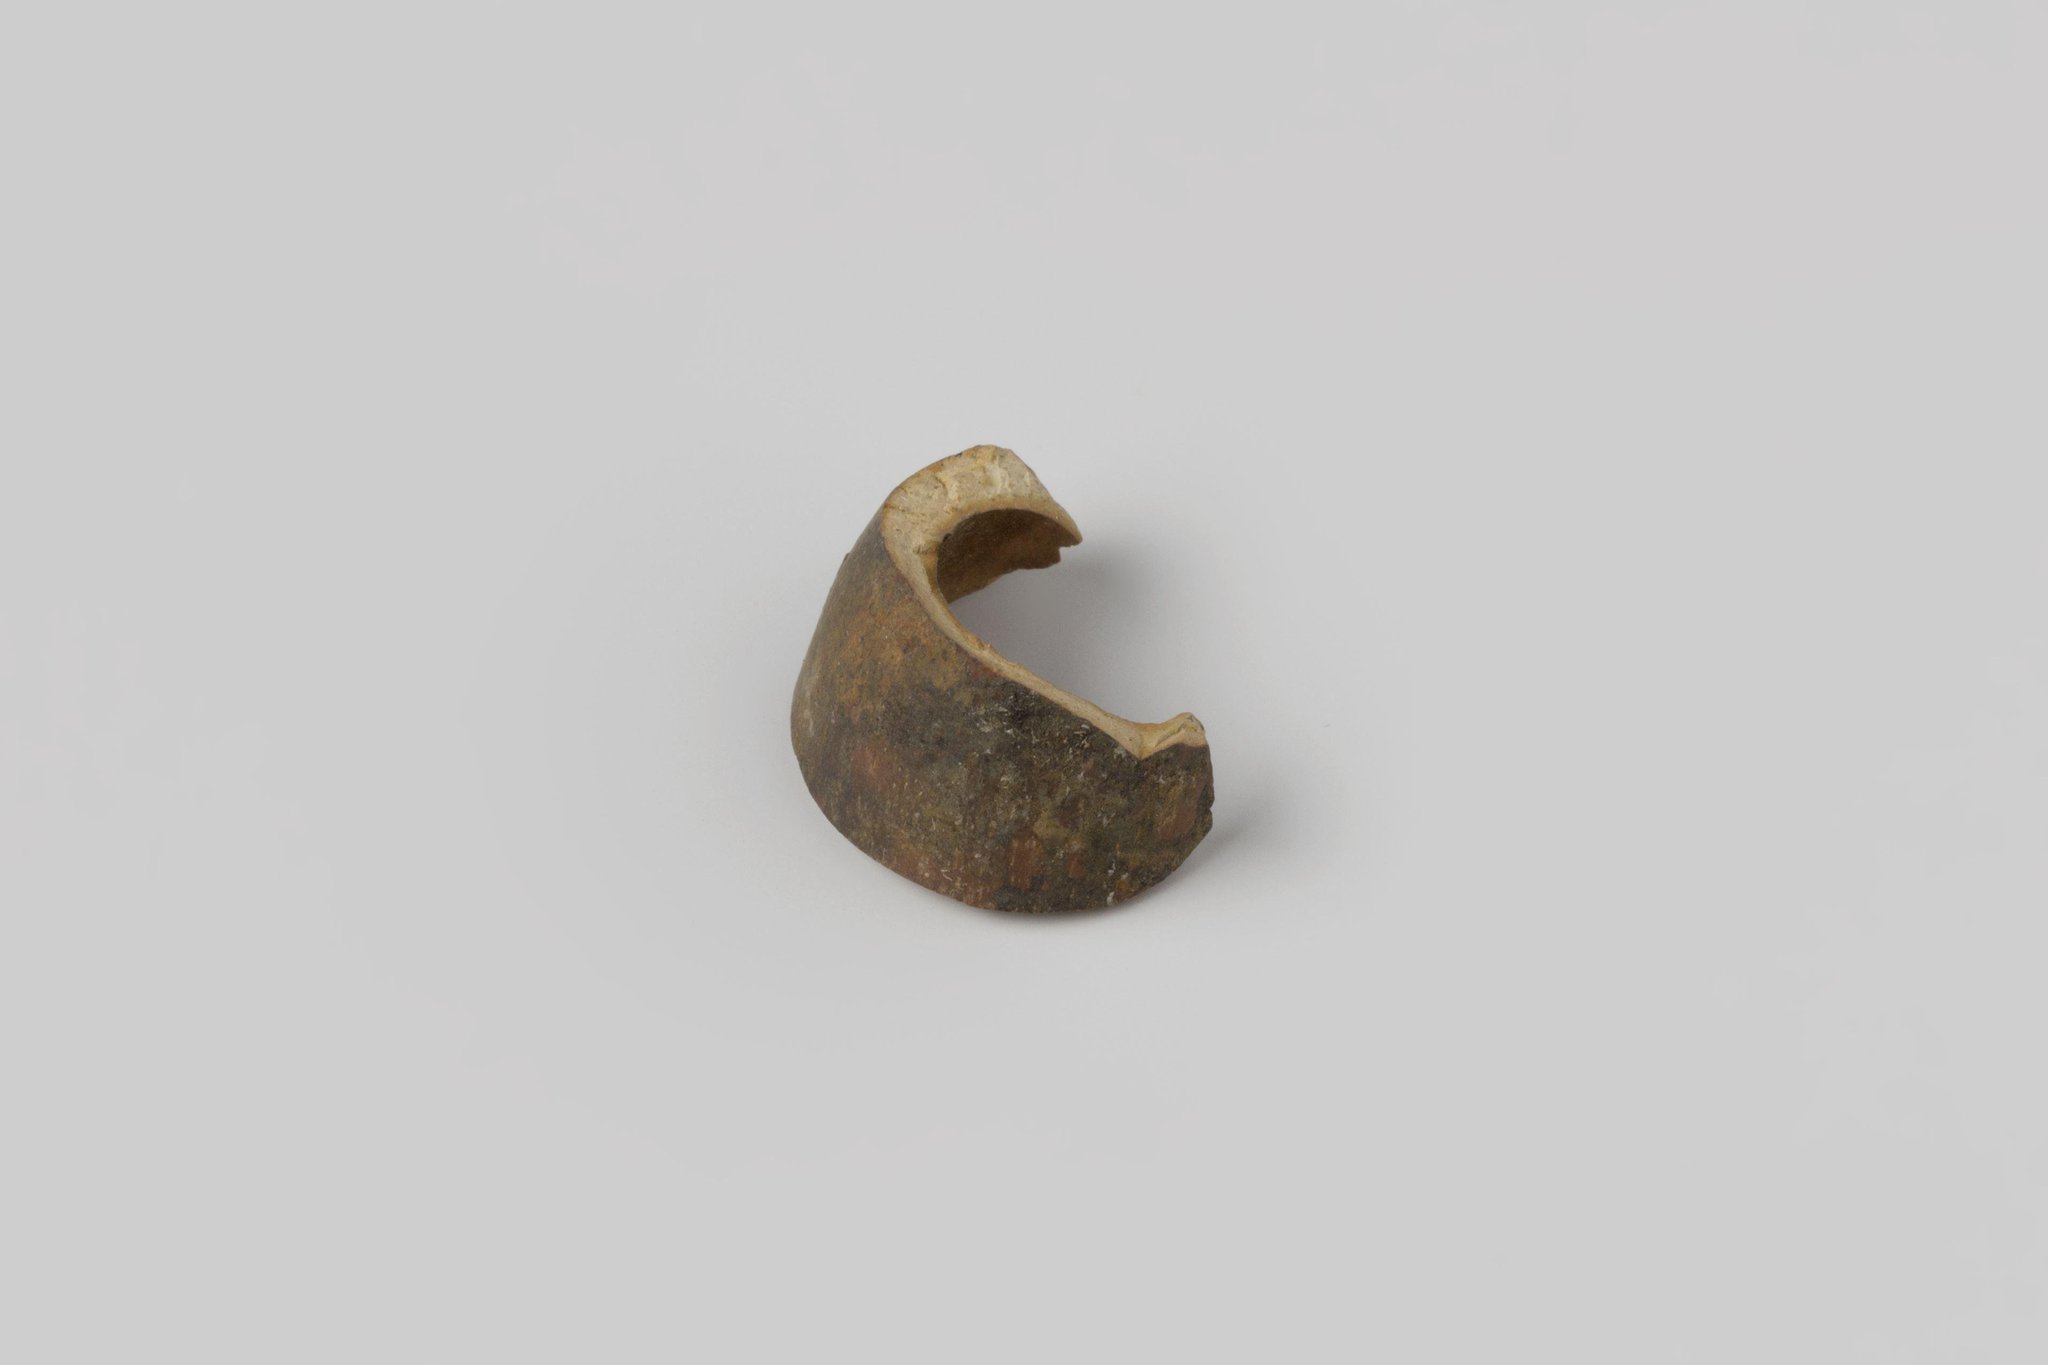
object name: pipe bowl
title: Fragment pijpenkop uit het wrak van de Oost-Indiëvaarder Hollandia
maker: Anonymous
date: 1700-1743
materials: clay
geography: netherlands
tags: verenigde oostindische compagnie, hollandia (schip), annet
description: Pipe, bowl, heelmark illegible; fragment.